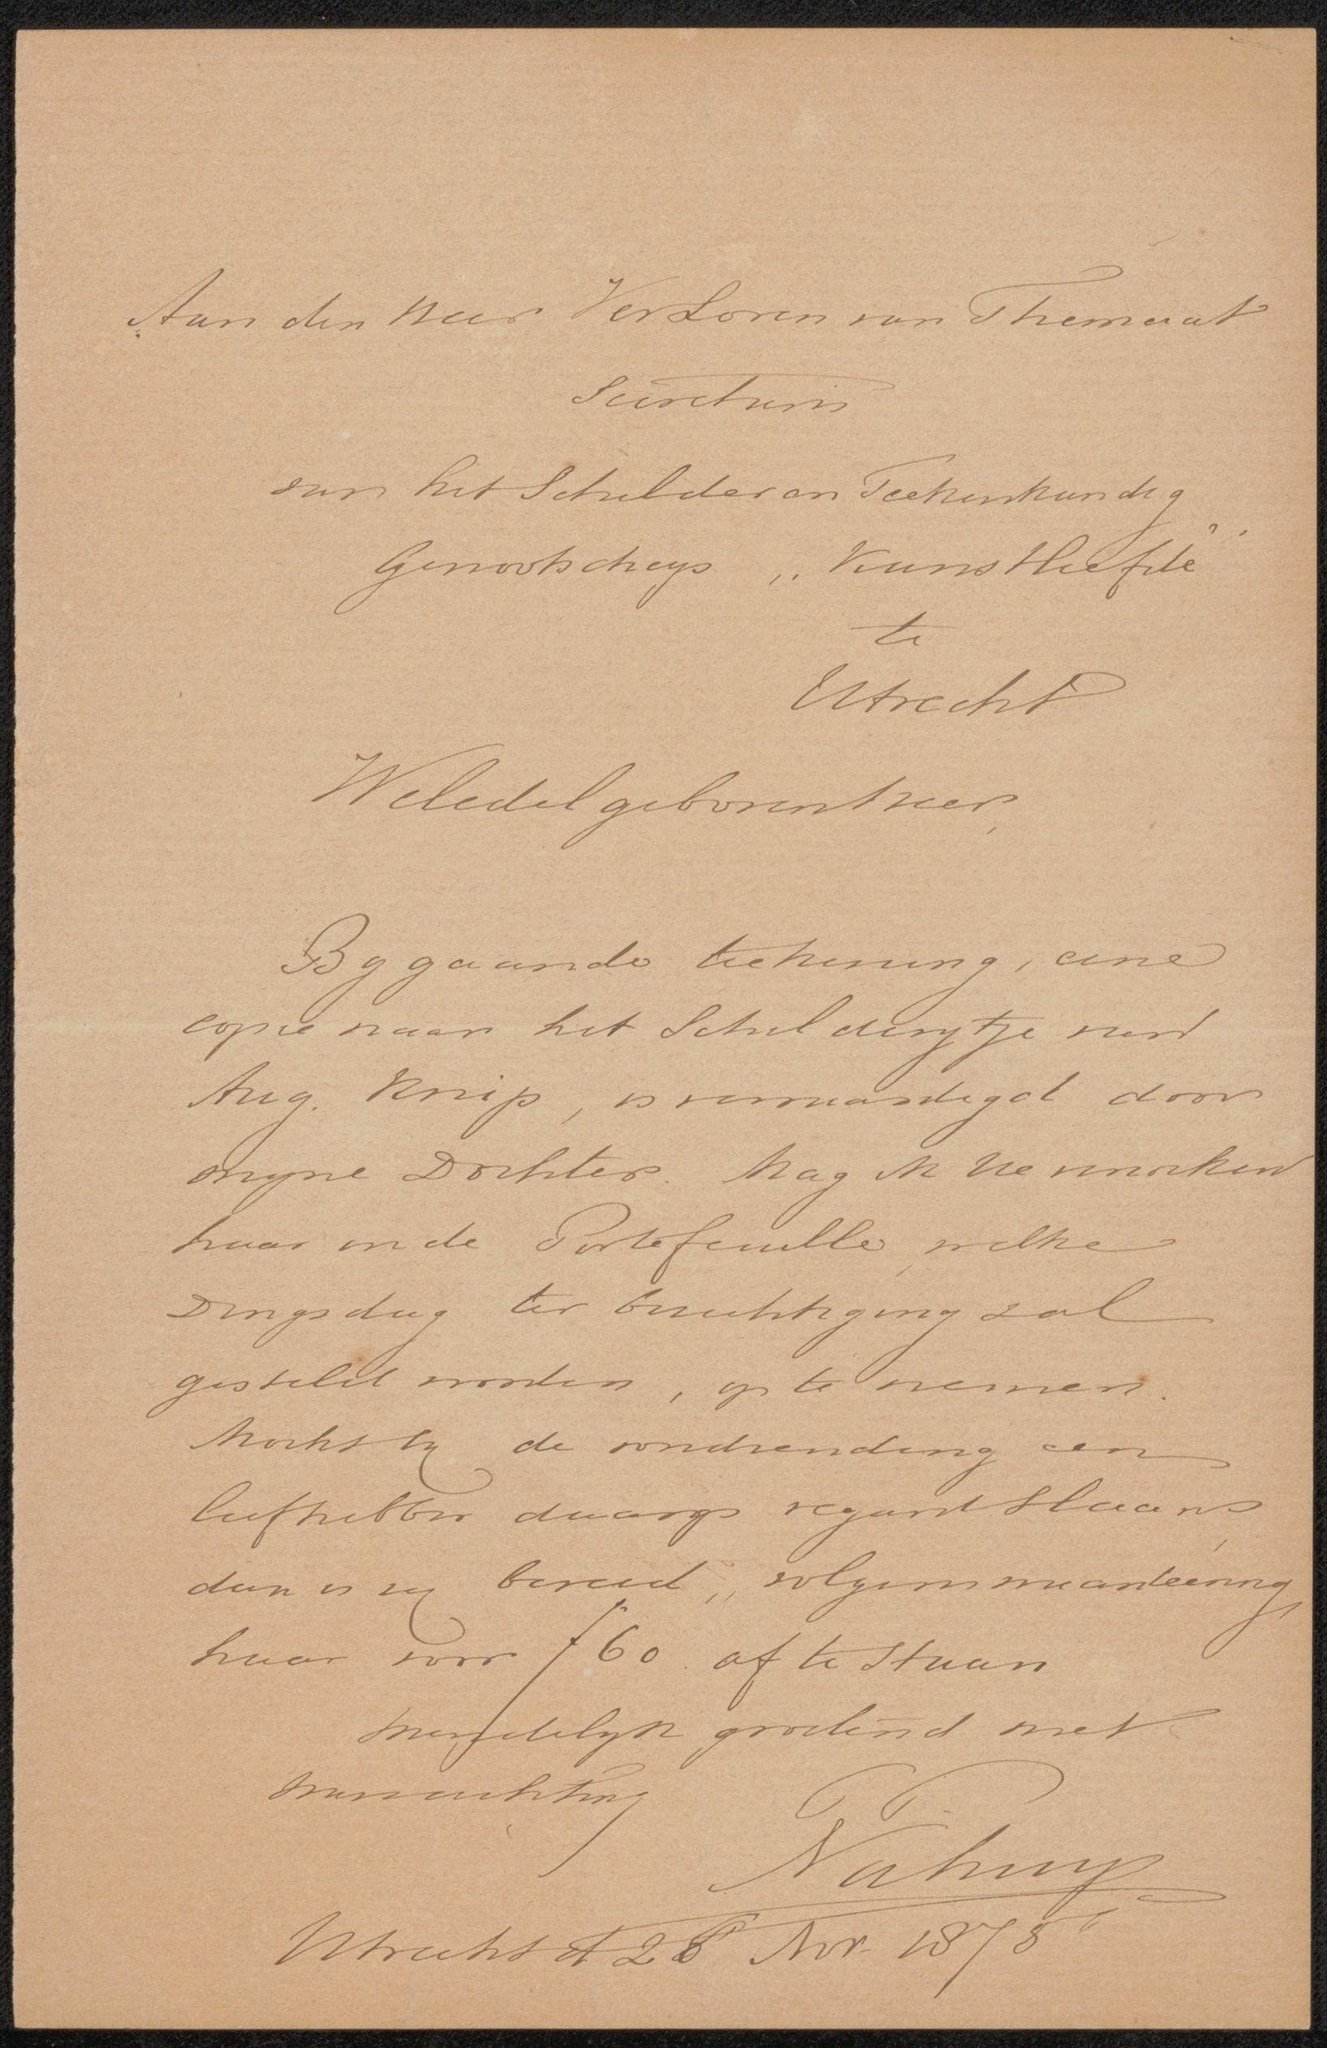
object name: letter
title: Brief aan Pieter Verloren van Themaat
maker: Anonymous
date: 1878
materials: ink, paper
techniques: pen, writing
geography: utrecht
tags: utrecht, pieter verloren van themaat, painter, print maker, draughtsman, josephus augustus knip, drawing, painting (including book-illumination, miniature-painting), exhibition ~ art, money